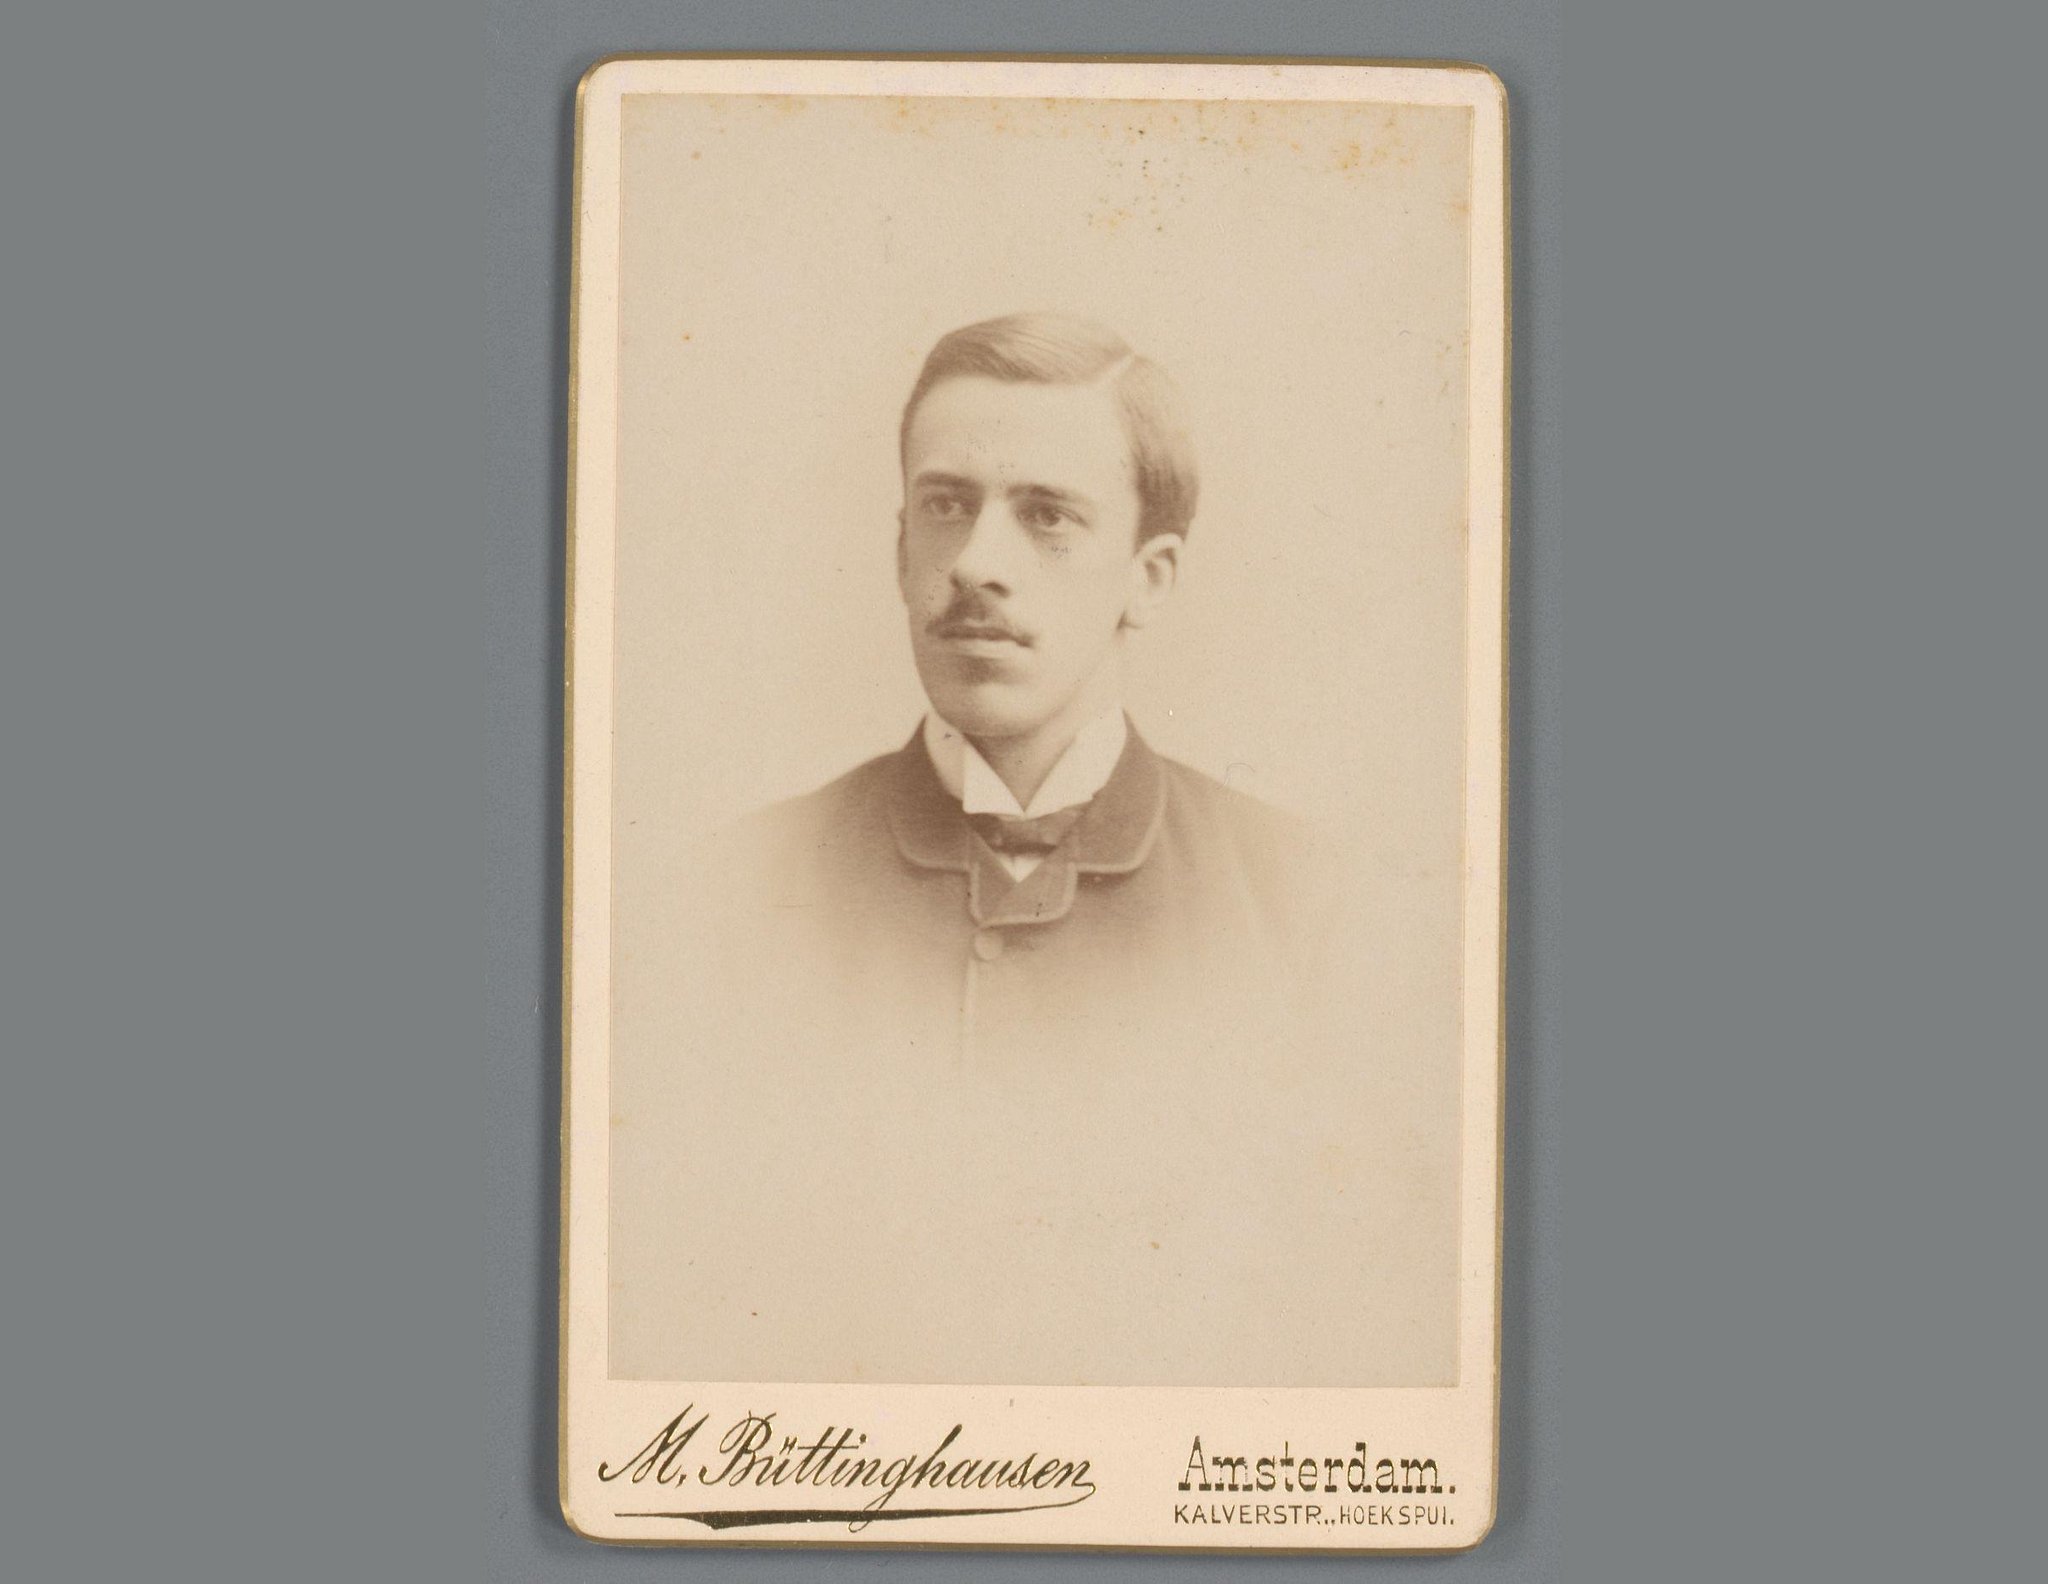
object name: photograph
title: Portret van een onbekende man, mogelijk een lid van de familie Onnen-van den Berg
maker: max büttinghausen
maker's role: fotograaf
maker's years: 1847-1906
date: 1886-1906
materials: cardboard, paper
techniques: albumen print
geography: amsterdam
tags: anonymous historical person portrayed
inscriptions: address: ‘Amsterdam./ KALVERSTR., HOEK SPUI.’